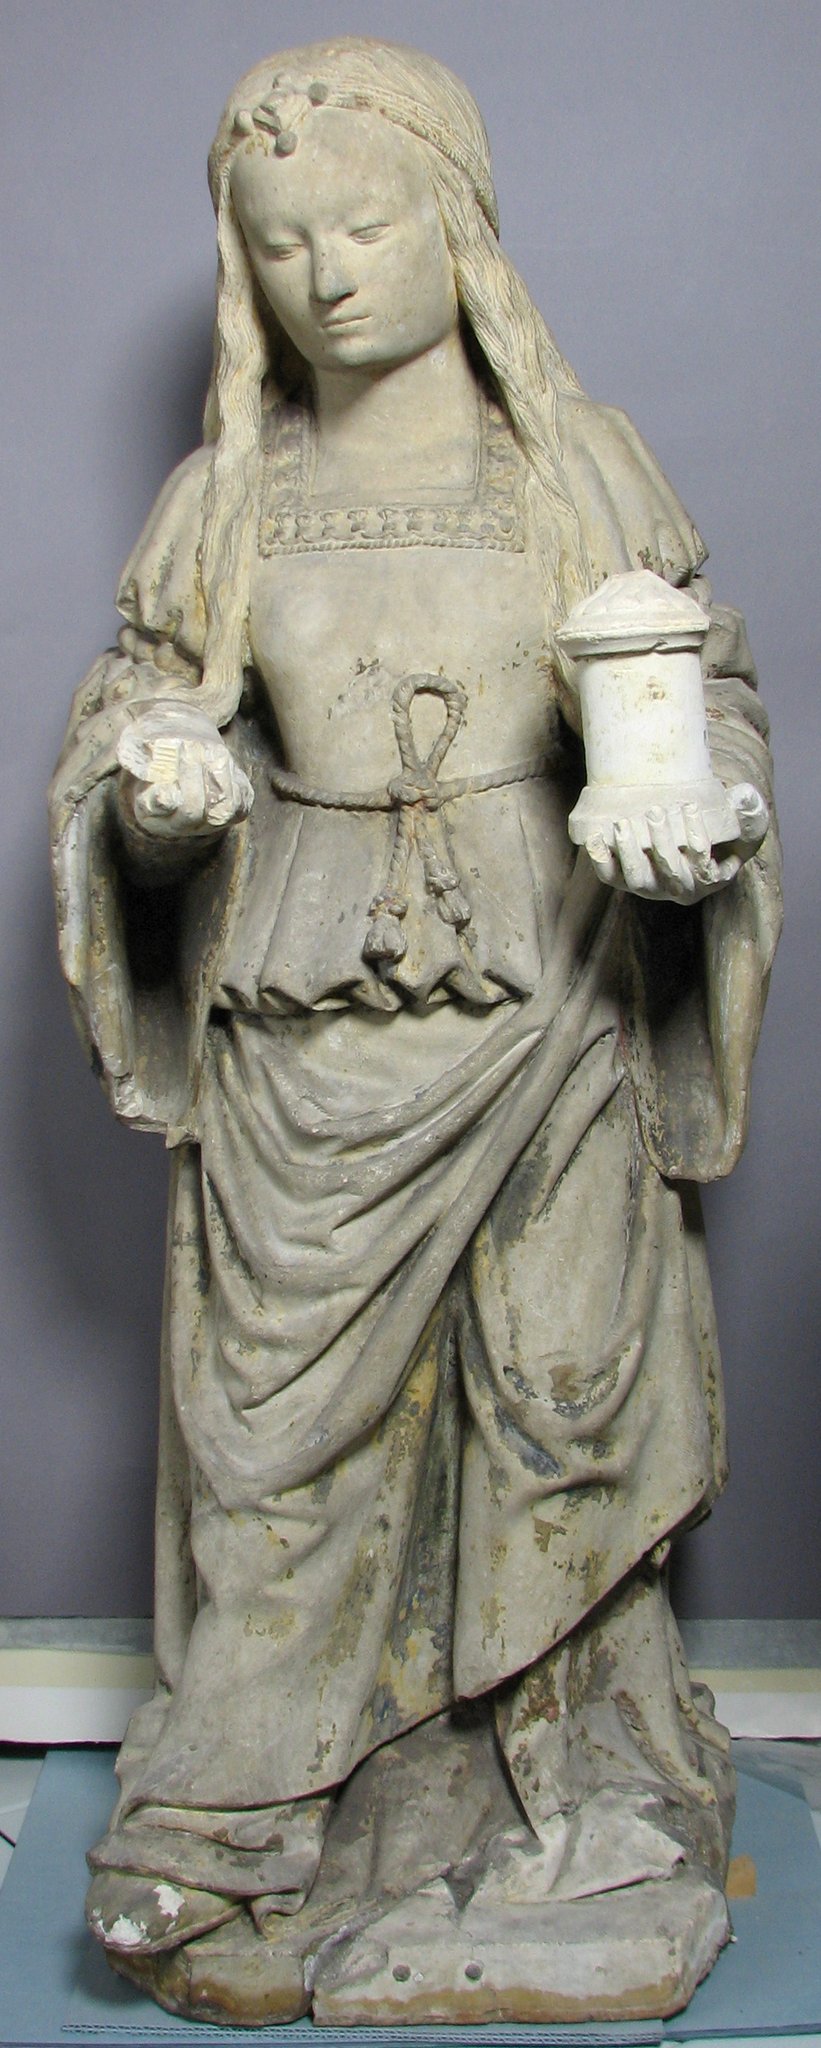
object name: statue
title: Mary Magdalene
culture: french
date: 1501-1600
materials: paint, stone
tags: women,mary magdalene